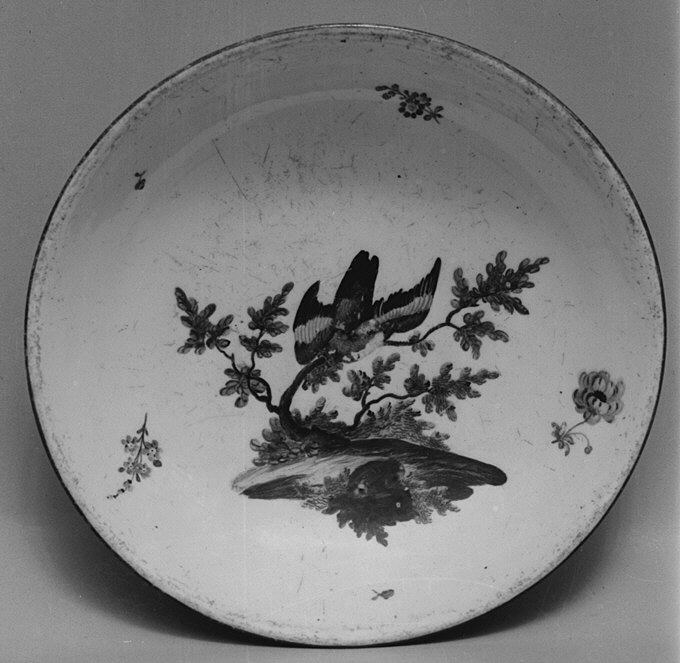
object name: saucer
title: Saucer (part of a service)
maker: frankenthal porcelain manufactory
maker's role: manufactory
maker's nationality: german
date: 1770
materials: hard paste porcelain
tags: birds,flowers